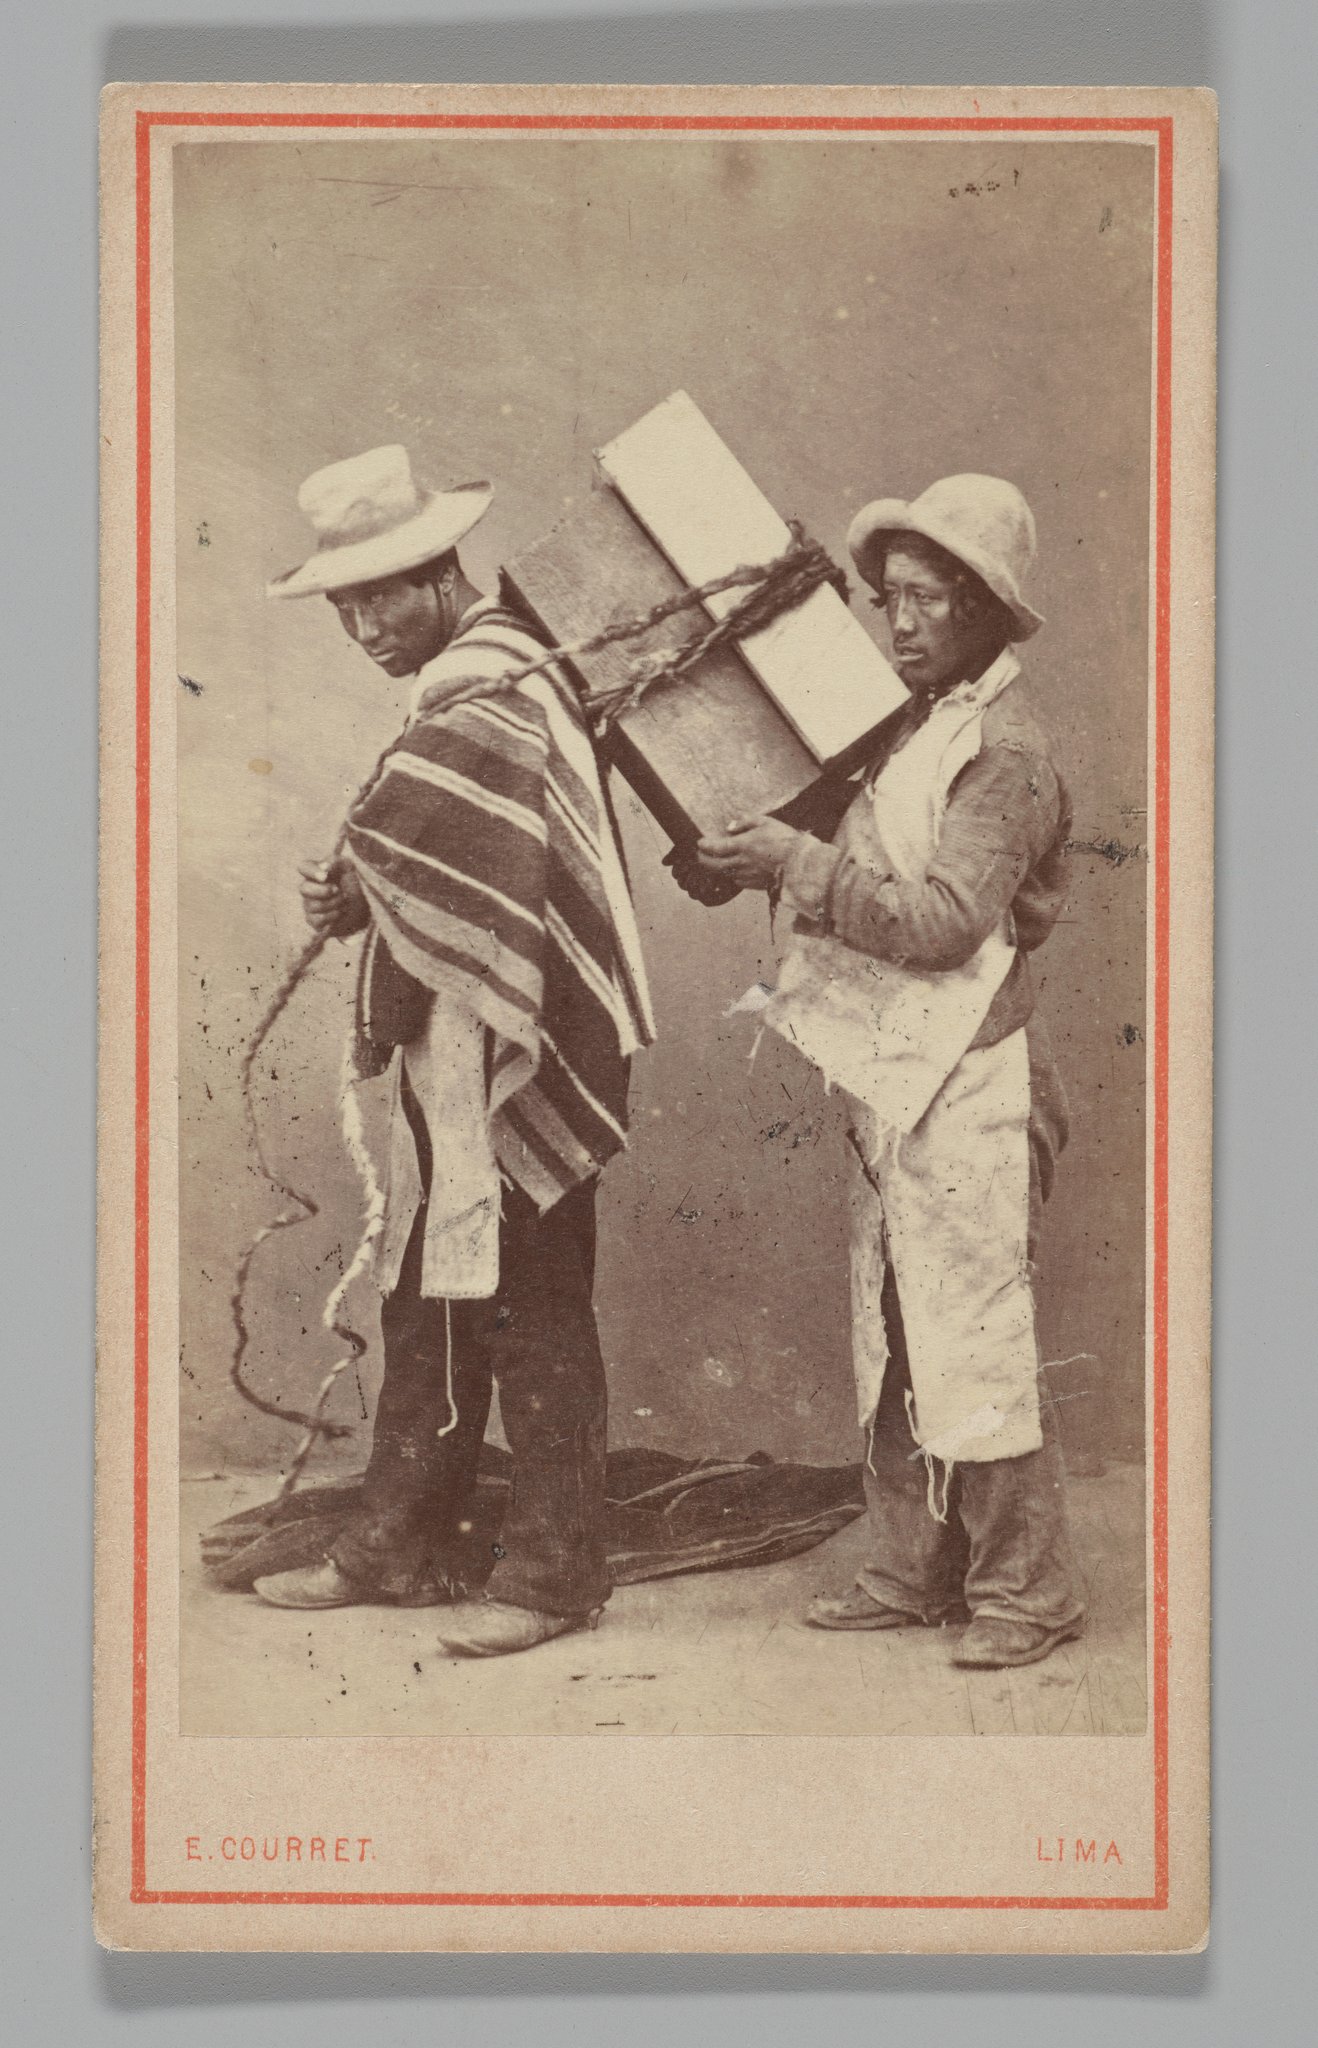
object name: carte de visite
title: [Studio Portrait: Two Men, one with Box Tied to his Back, Lima]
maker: eugenio courret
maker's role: artist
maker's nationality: french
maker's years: 1839-1920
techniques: albumen silver print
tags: men,portraits